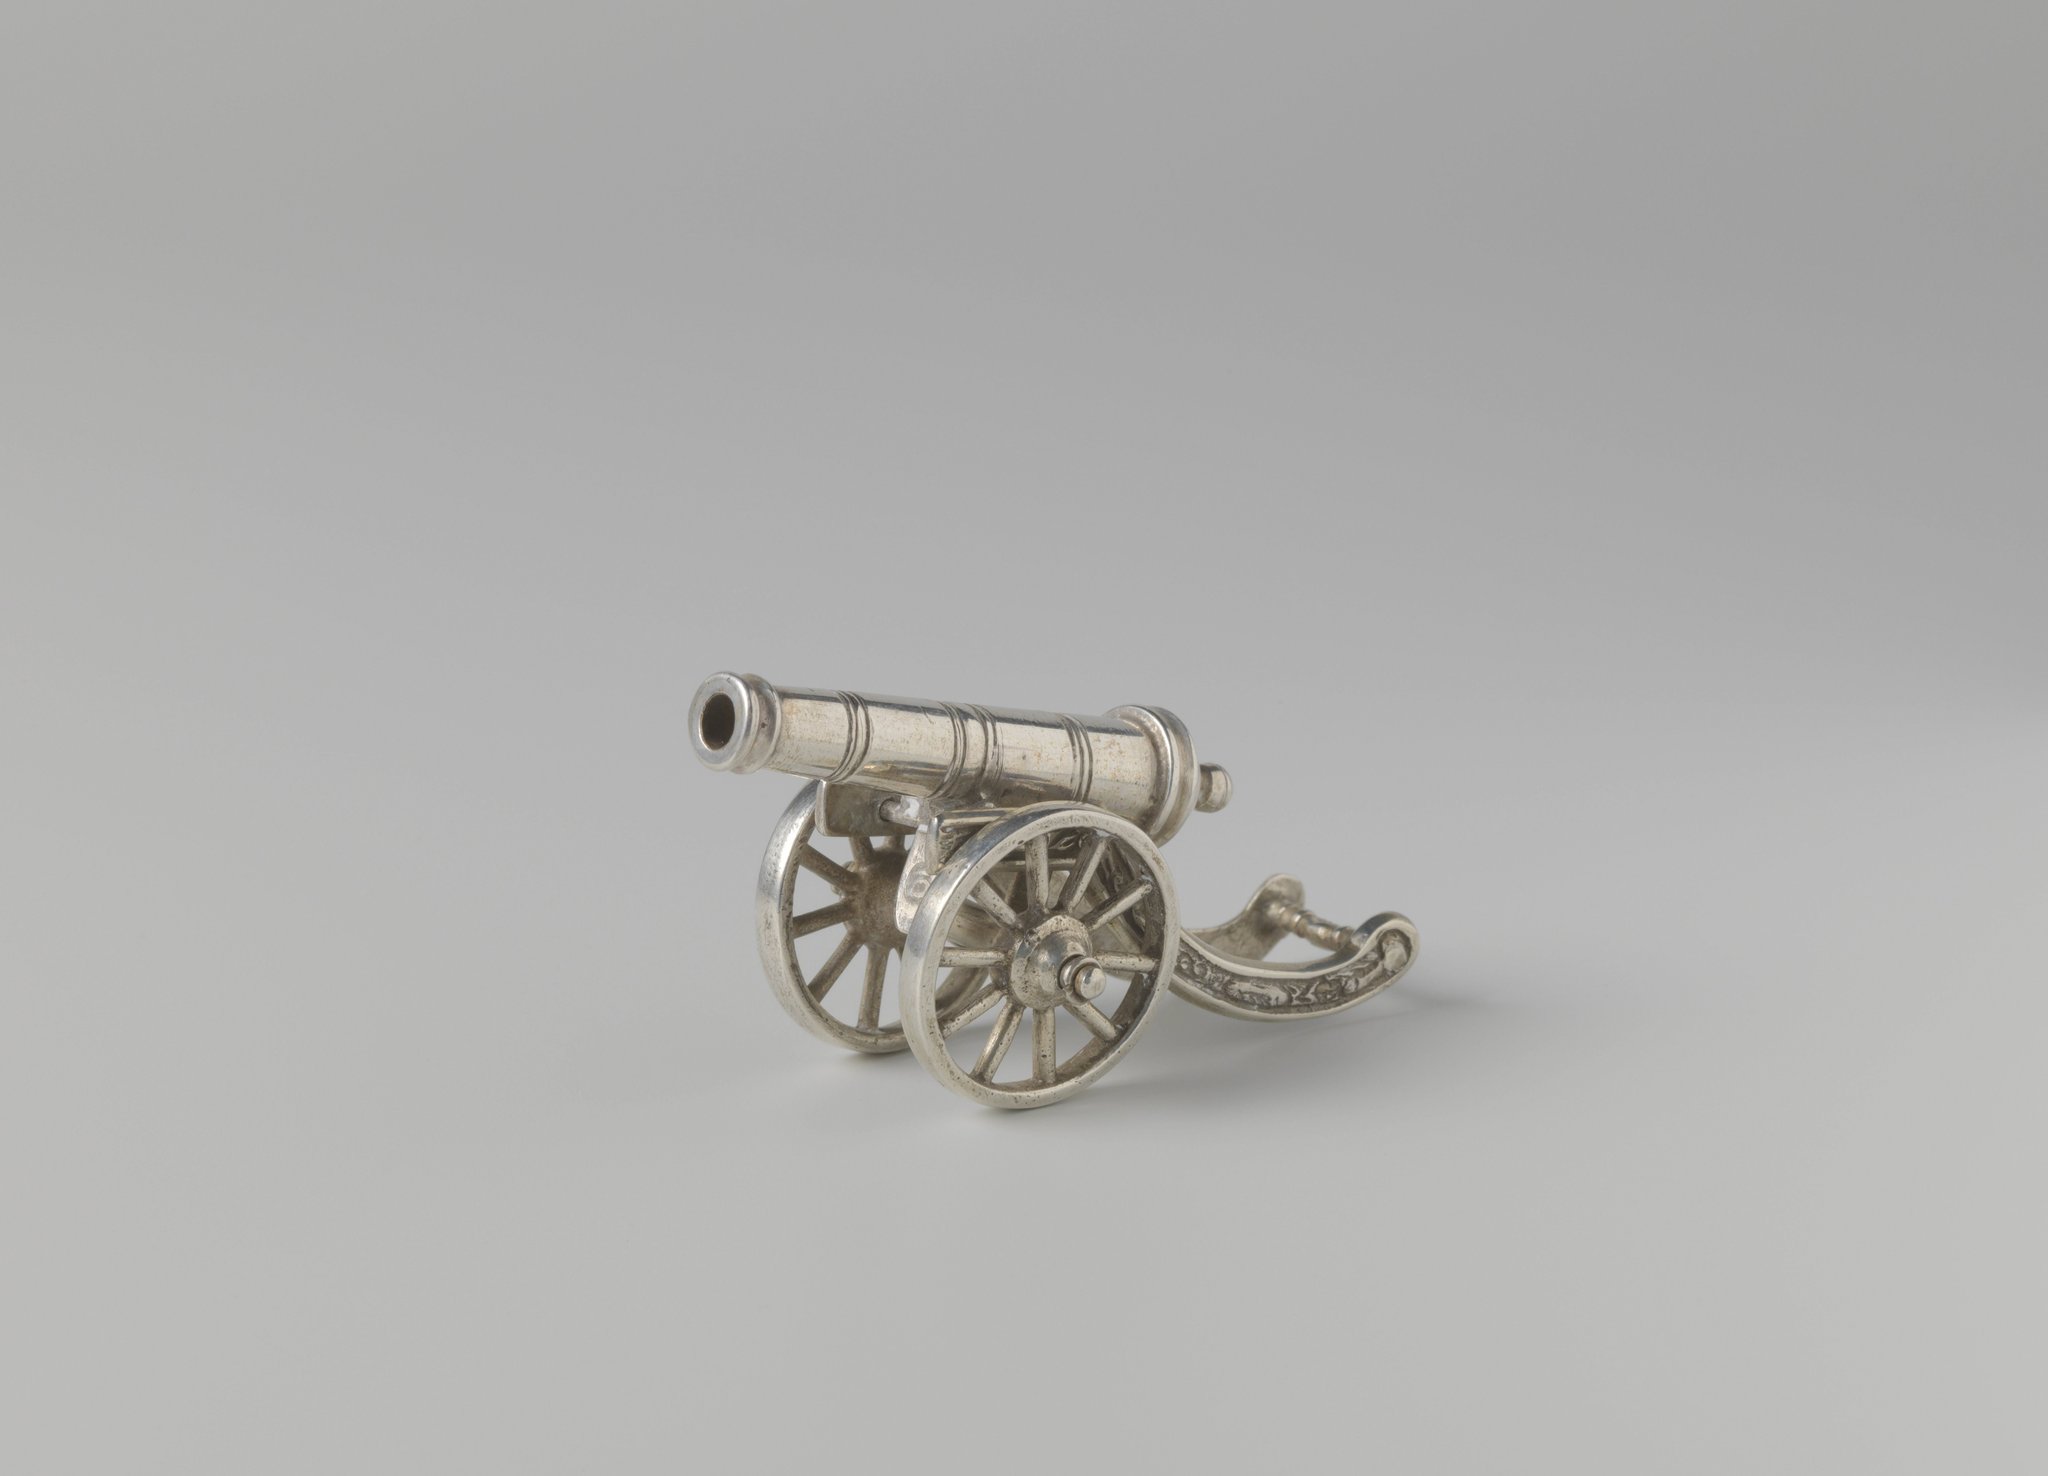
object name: miniature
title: Kanon op affuit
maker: Anonymous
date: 1803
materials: silver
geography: amsterdam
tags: firearms: cannon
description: Kanon op een affuit. Het kanon is versierd met gegraveerde lijnen. De zijkanten van het affuit zijn versierd met bloemen in relief. Het affuit heeft een geprofileerde handgreep. Het kanon is gemerkt: stk.= Amsterdam, jrl.= U (1803), het getal 10 in een ovaal.